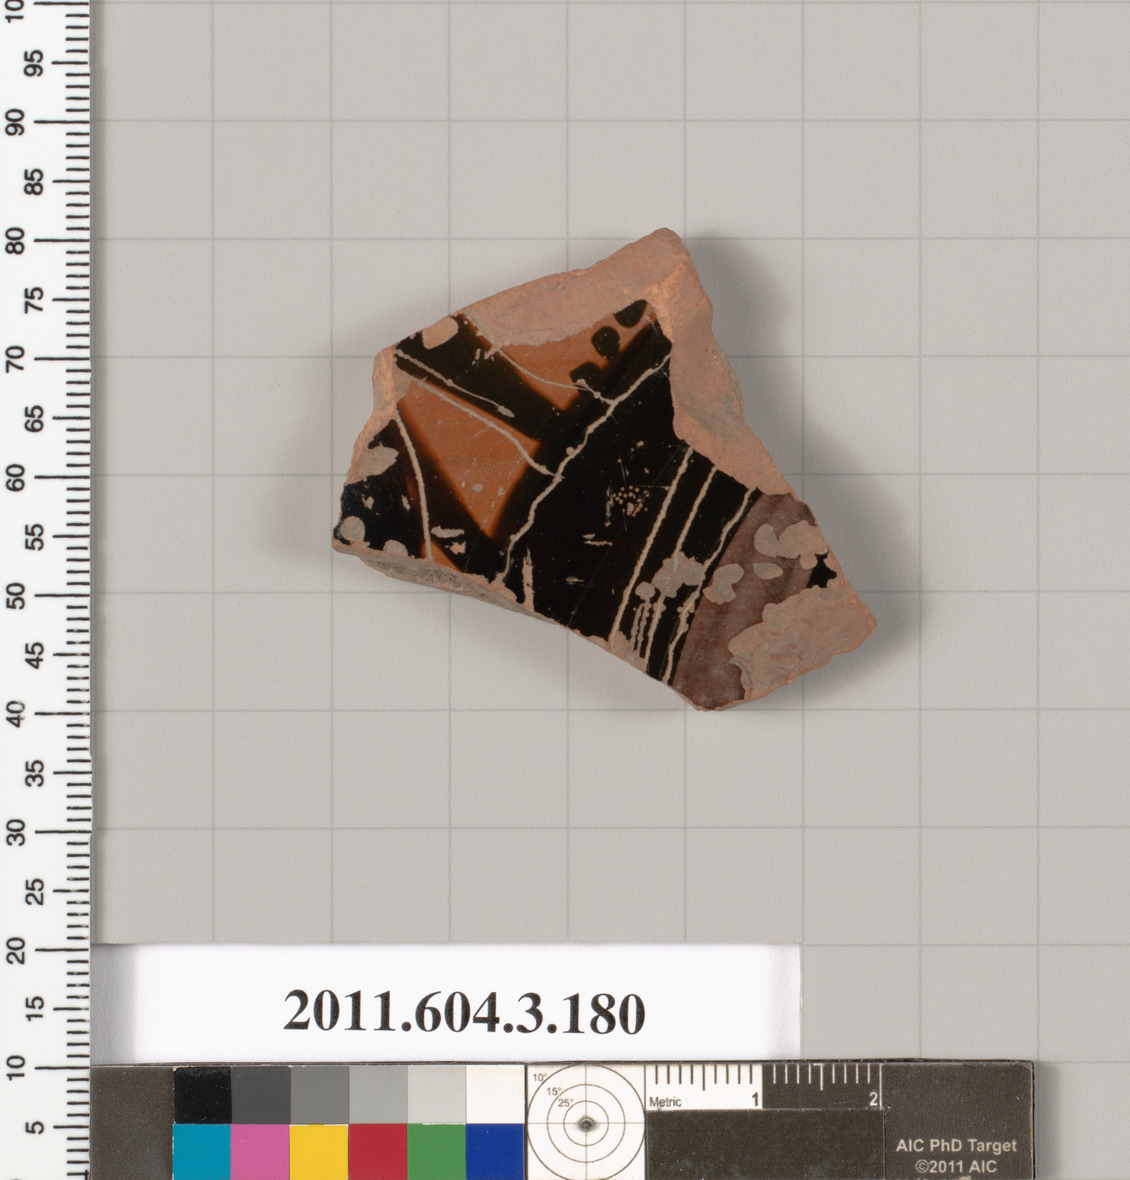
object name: amphora fragment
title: Terracotta fragment of an amphora (jar)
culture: greek, attic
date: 534-468 BCE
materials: terracotta